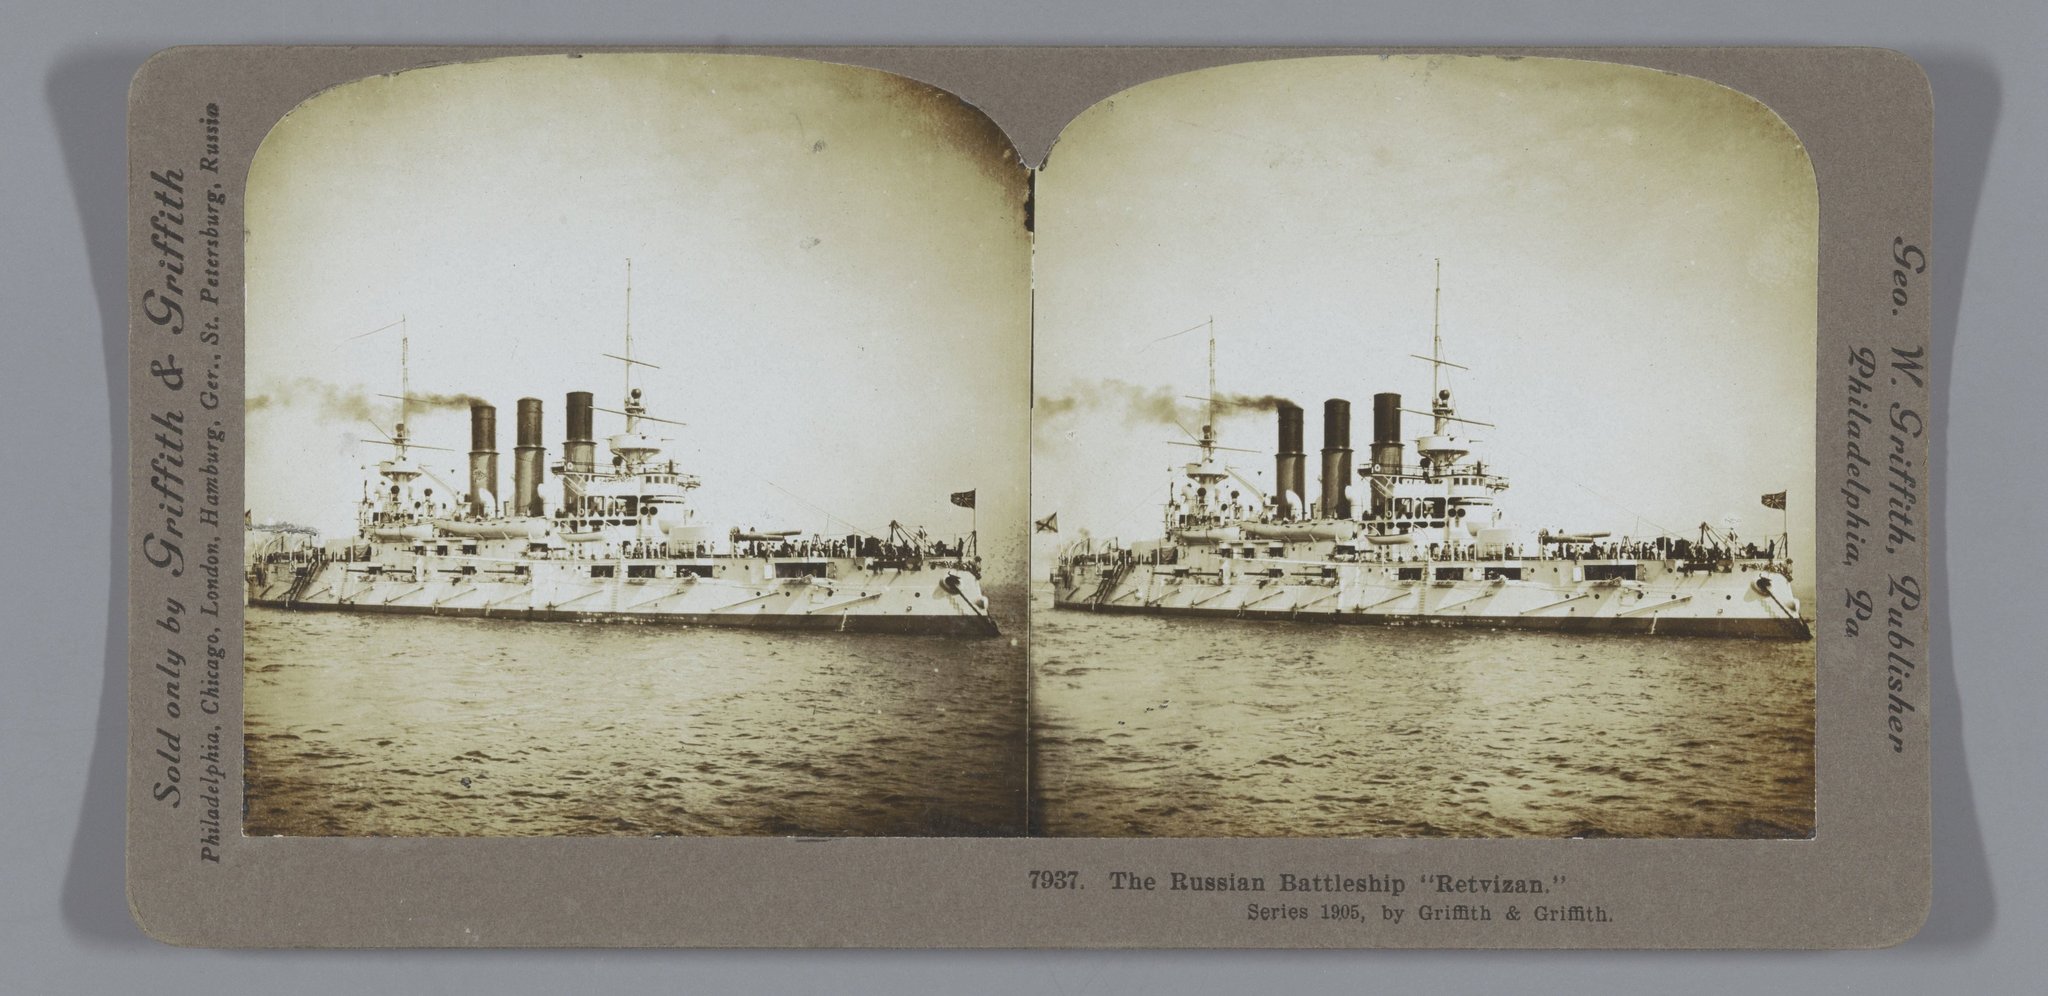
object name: stereograph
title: The Russian Battleship "Retvizan."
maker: Anonymous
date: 1905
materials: cardboard, photographic support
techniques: gelatin silver print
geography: russia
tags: (military) training ship, russia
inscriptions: inscription: ‘Sold only by Griffith & Griffith Philadelphia, Chicago, London, Hamburg, Ger., St. Petersburg, Russia’, number: ‘7937.’